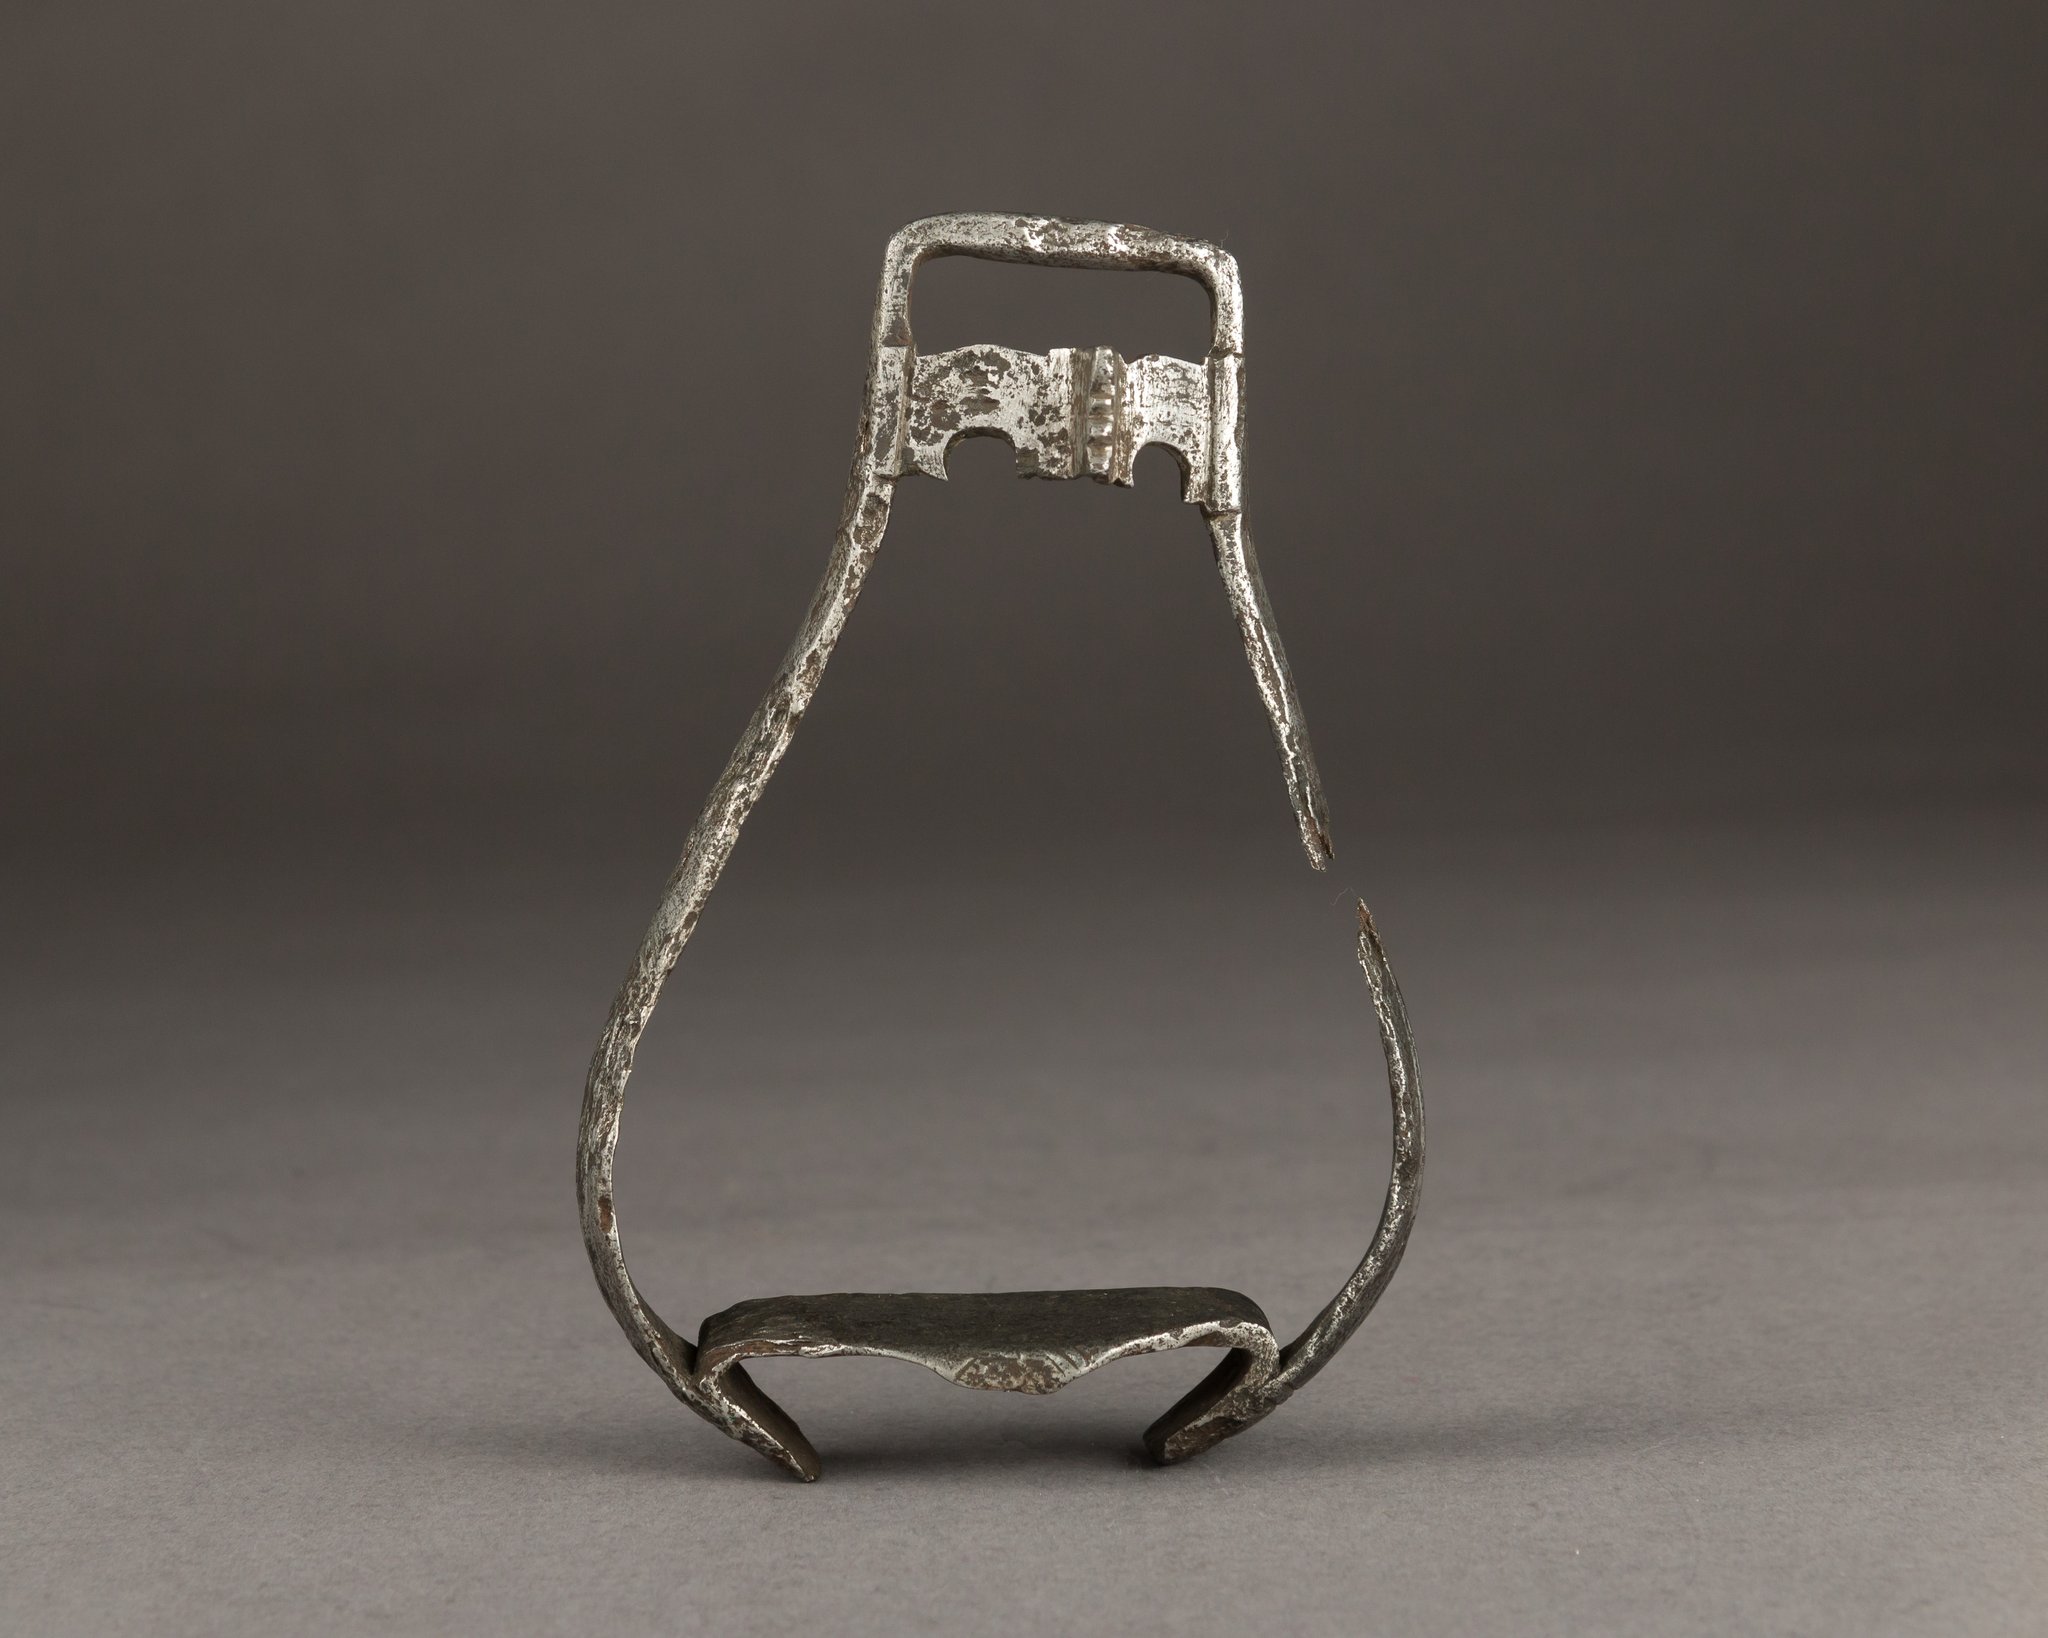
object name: stirrup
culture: german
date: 1451-1500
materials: iron, tin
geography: germany